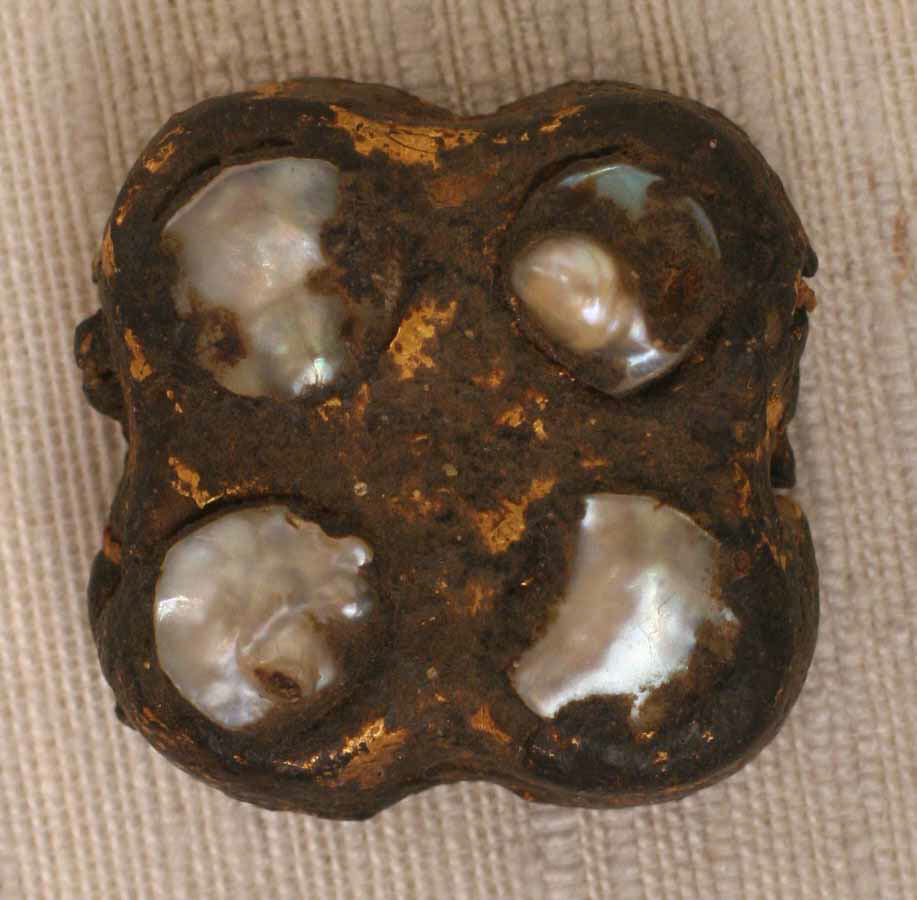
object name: plaque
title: Plaque for a Collar or Necklace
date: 701-800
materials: gold, mother of pearl, stone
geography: egypt